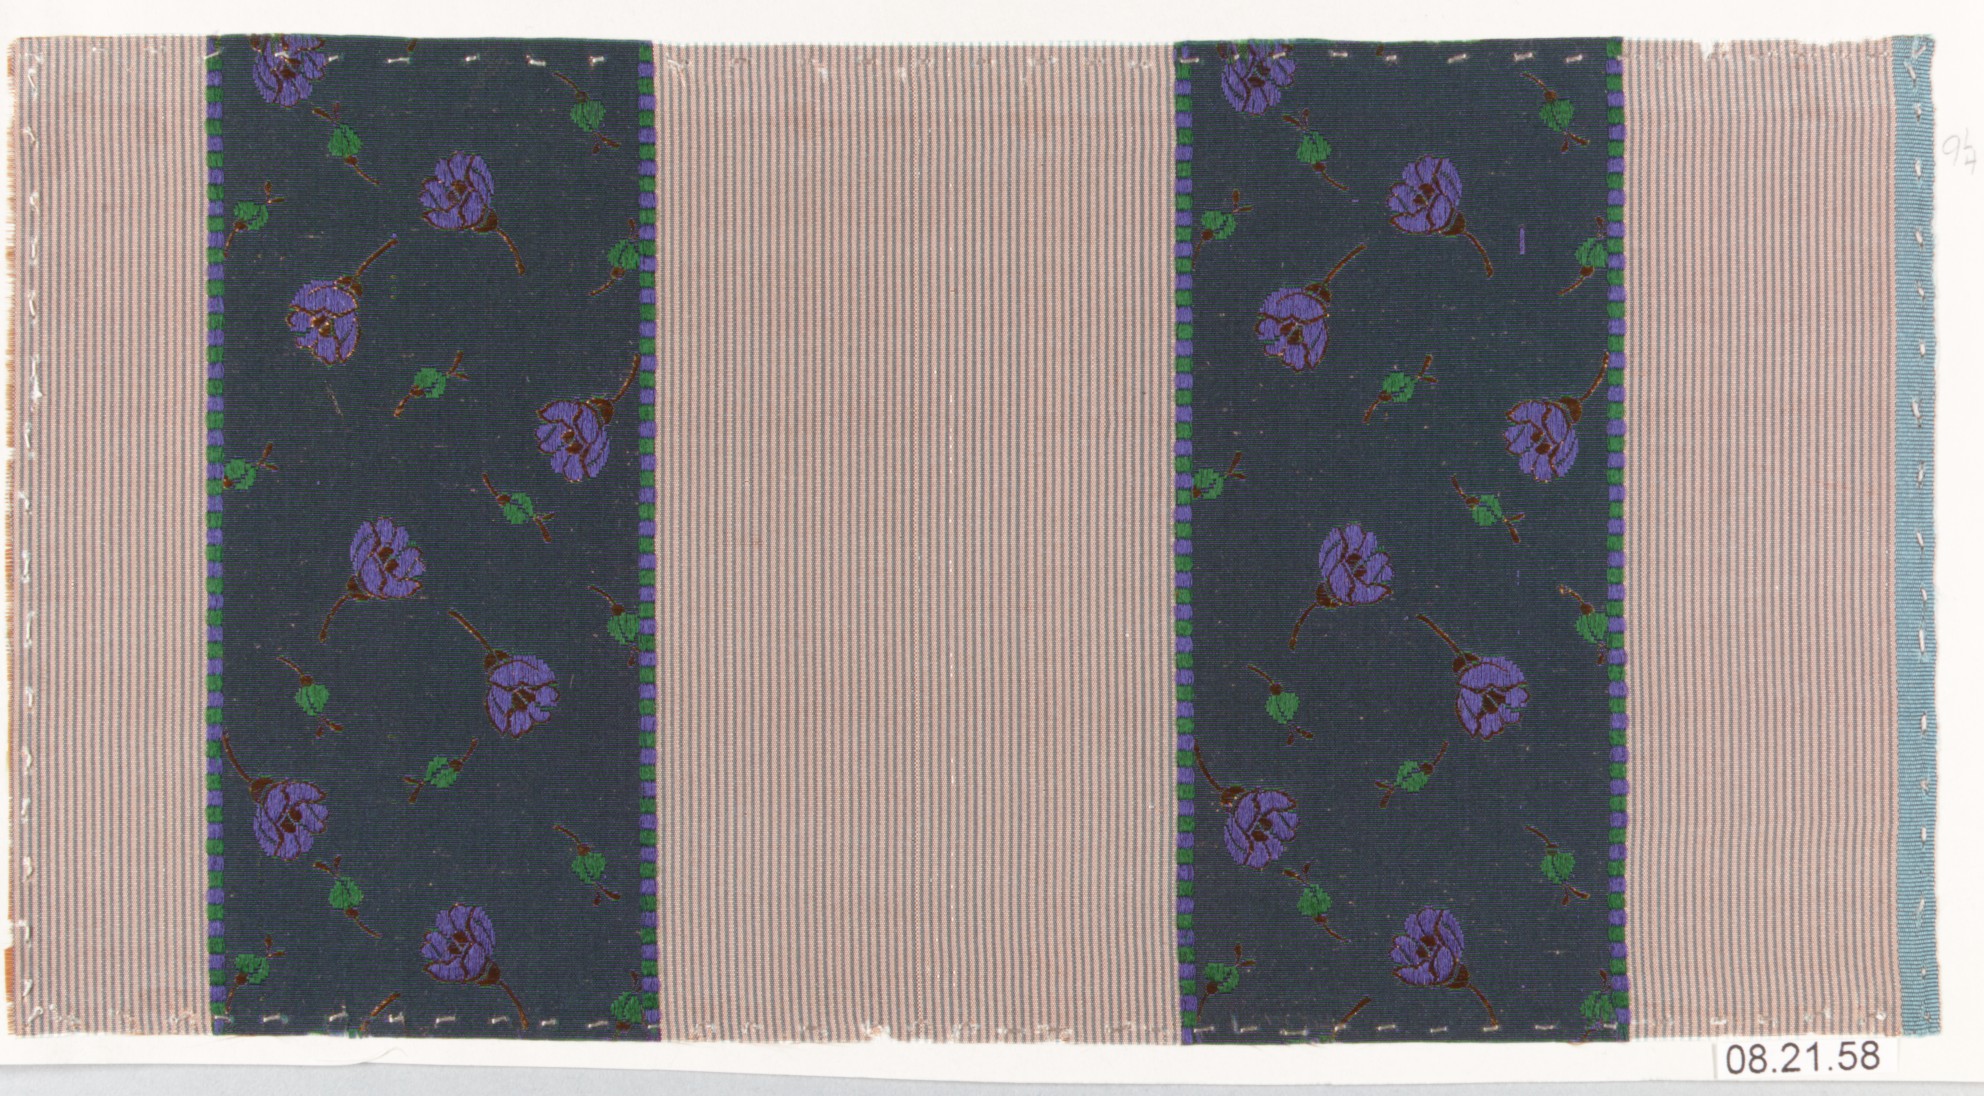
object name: textile sample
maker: Anonymous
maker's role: designer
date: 1900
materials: silk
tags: flowers